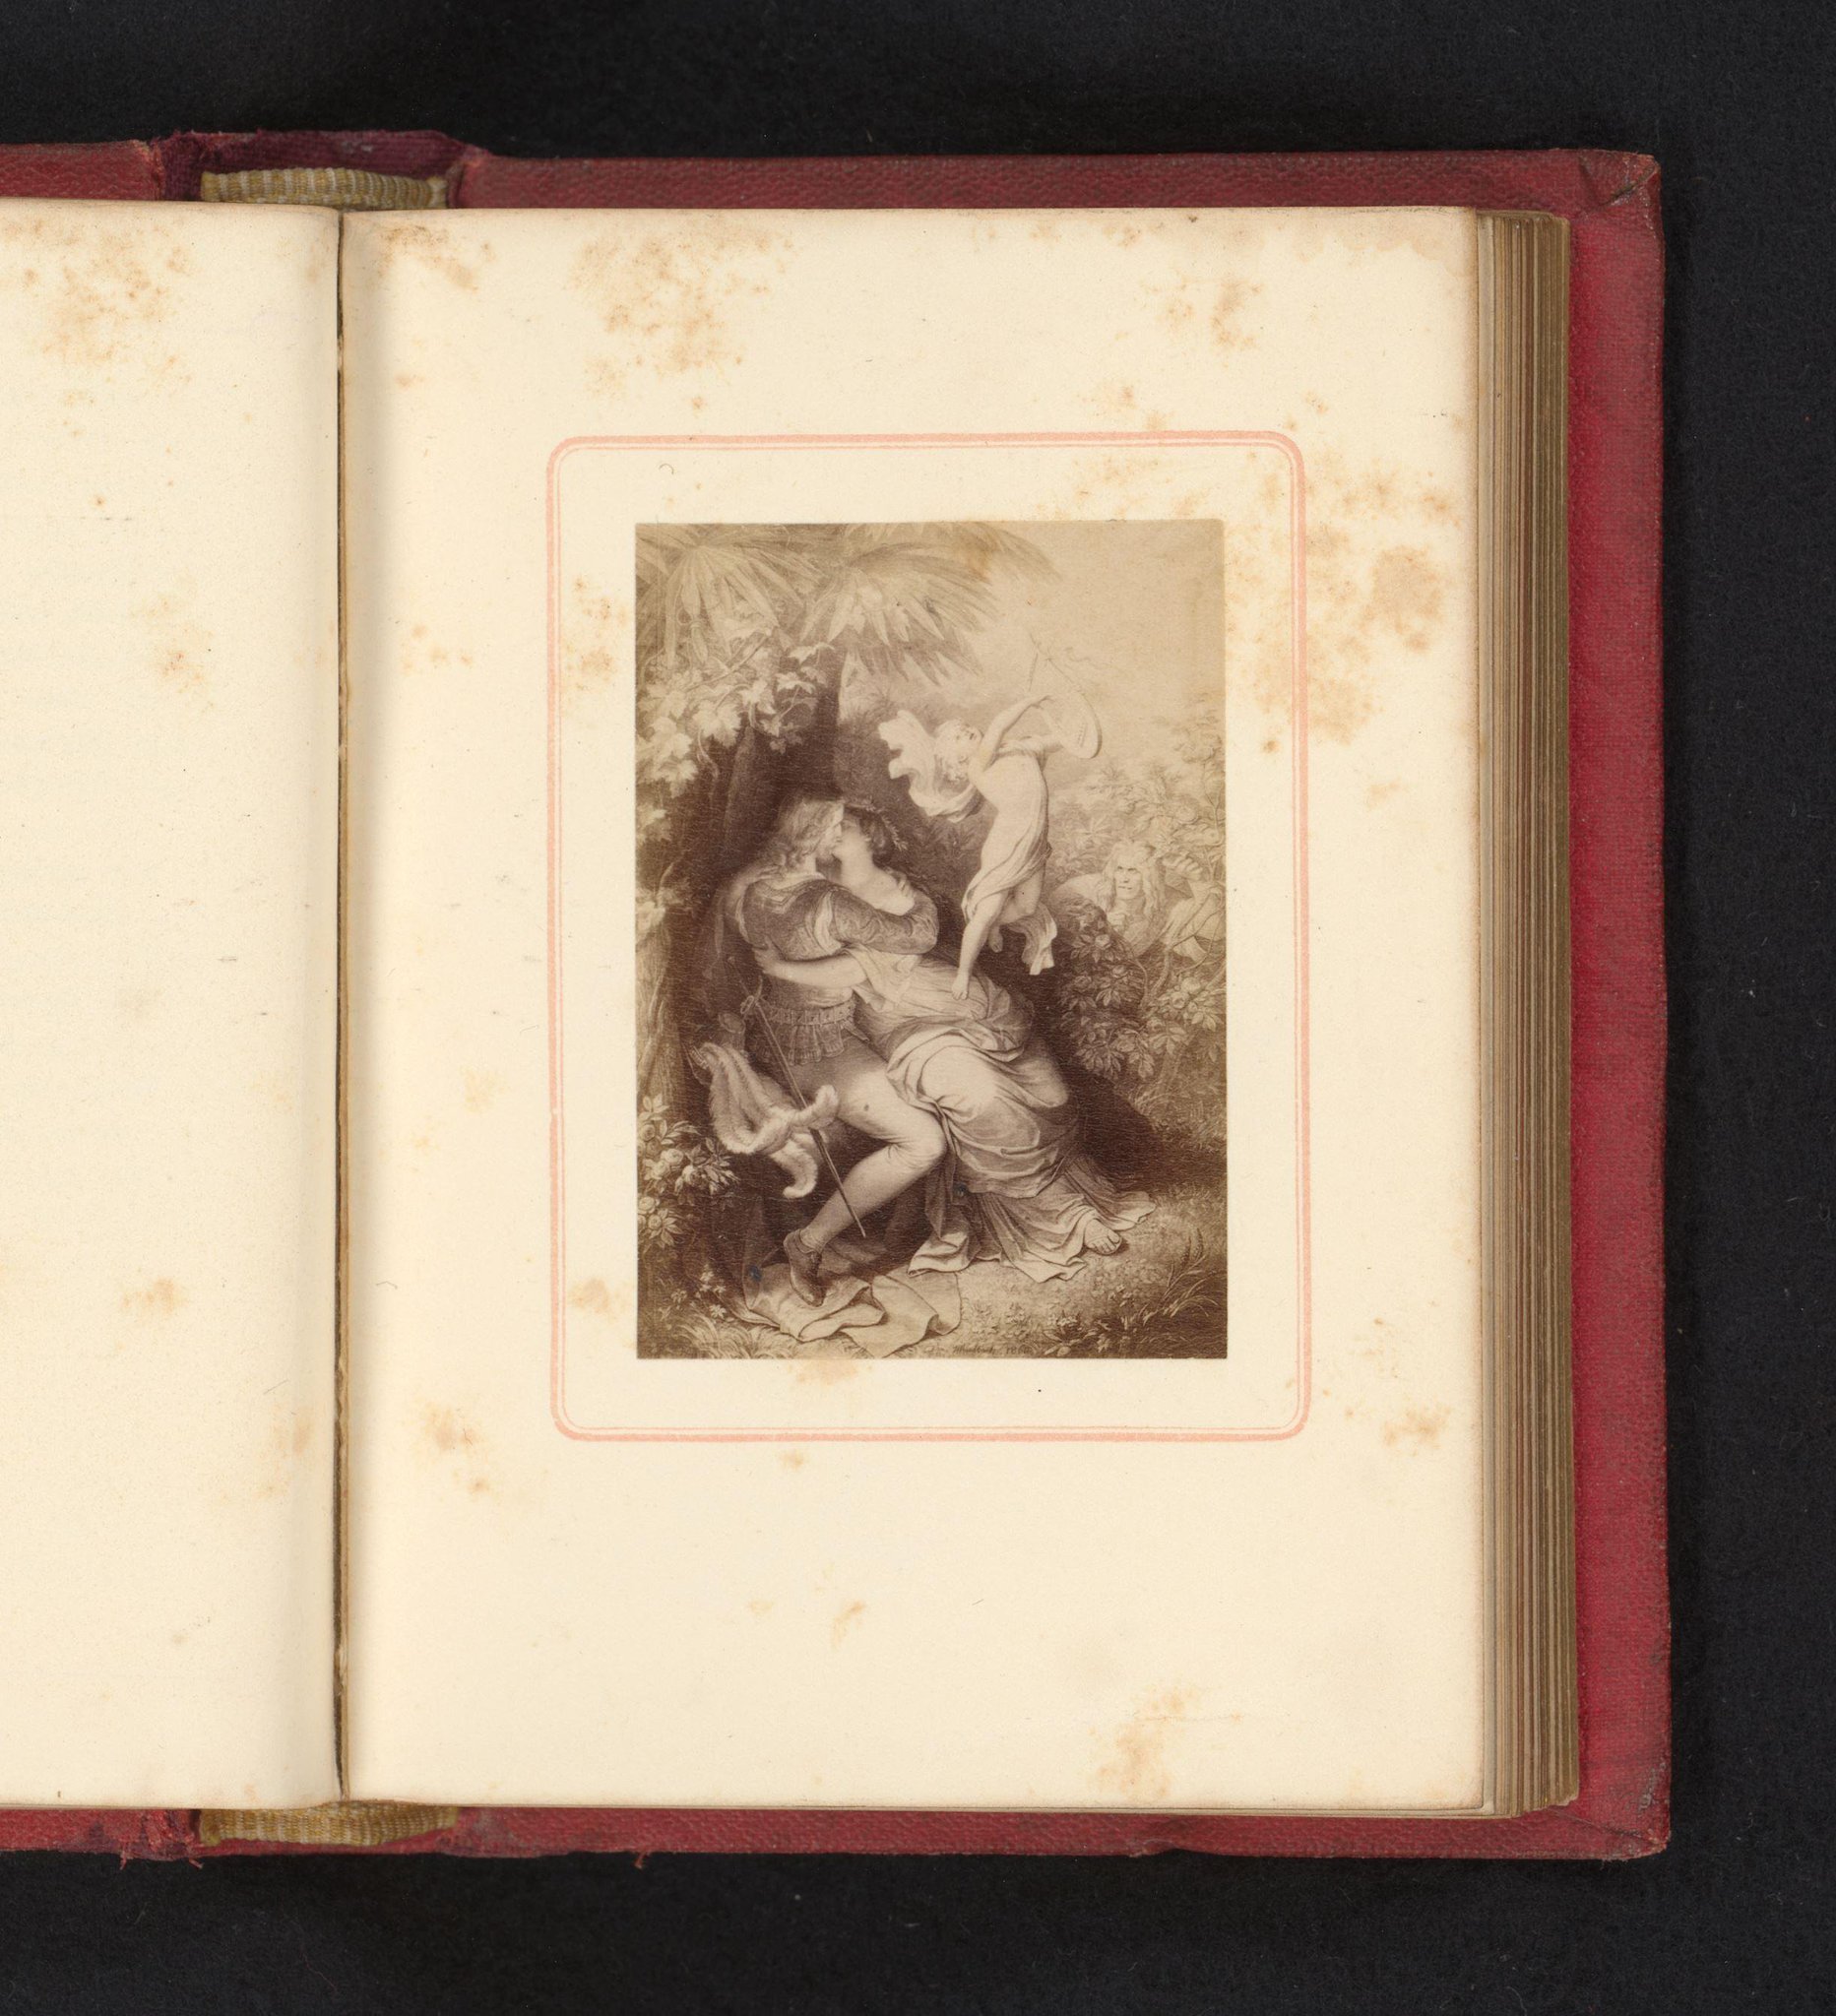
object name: reproduction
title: Helena. Faust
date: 1860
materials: paper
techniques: albumen print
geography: munich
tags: drawing, sketch, female literary characters